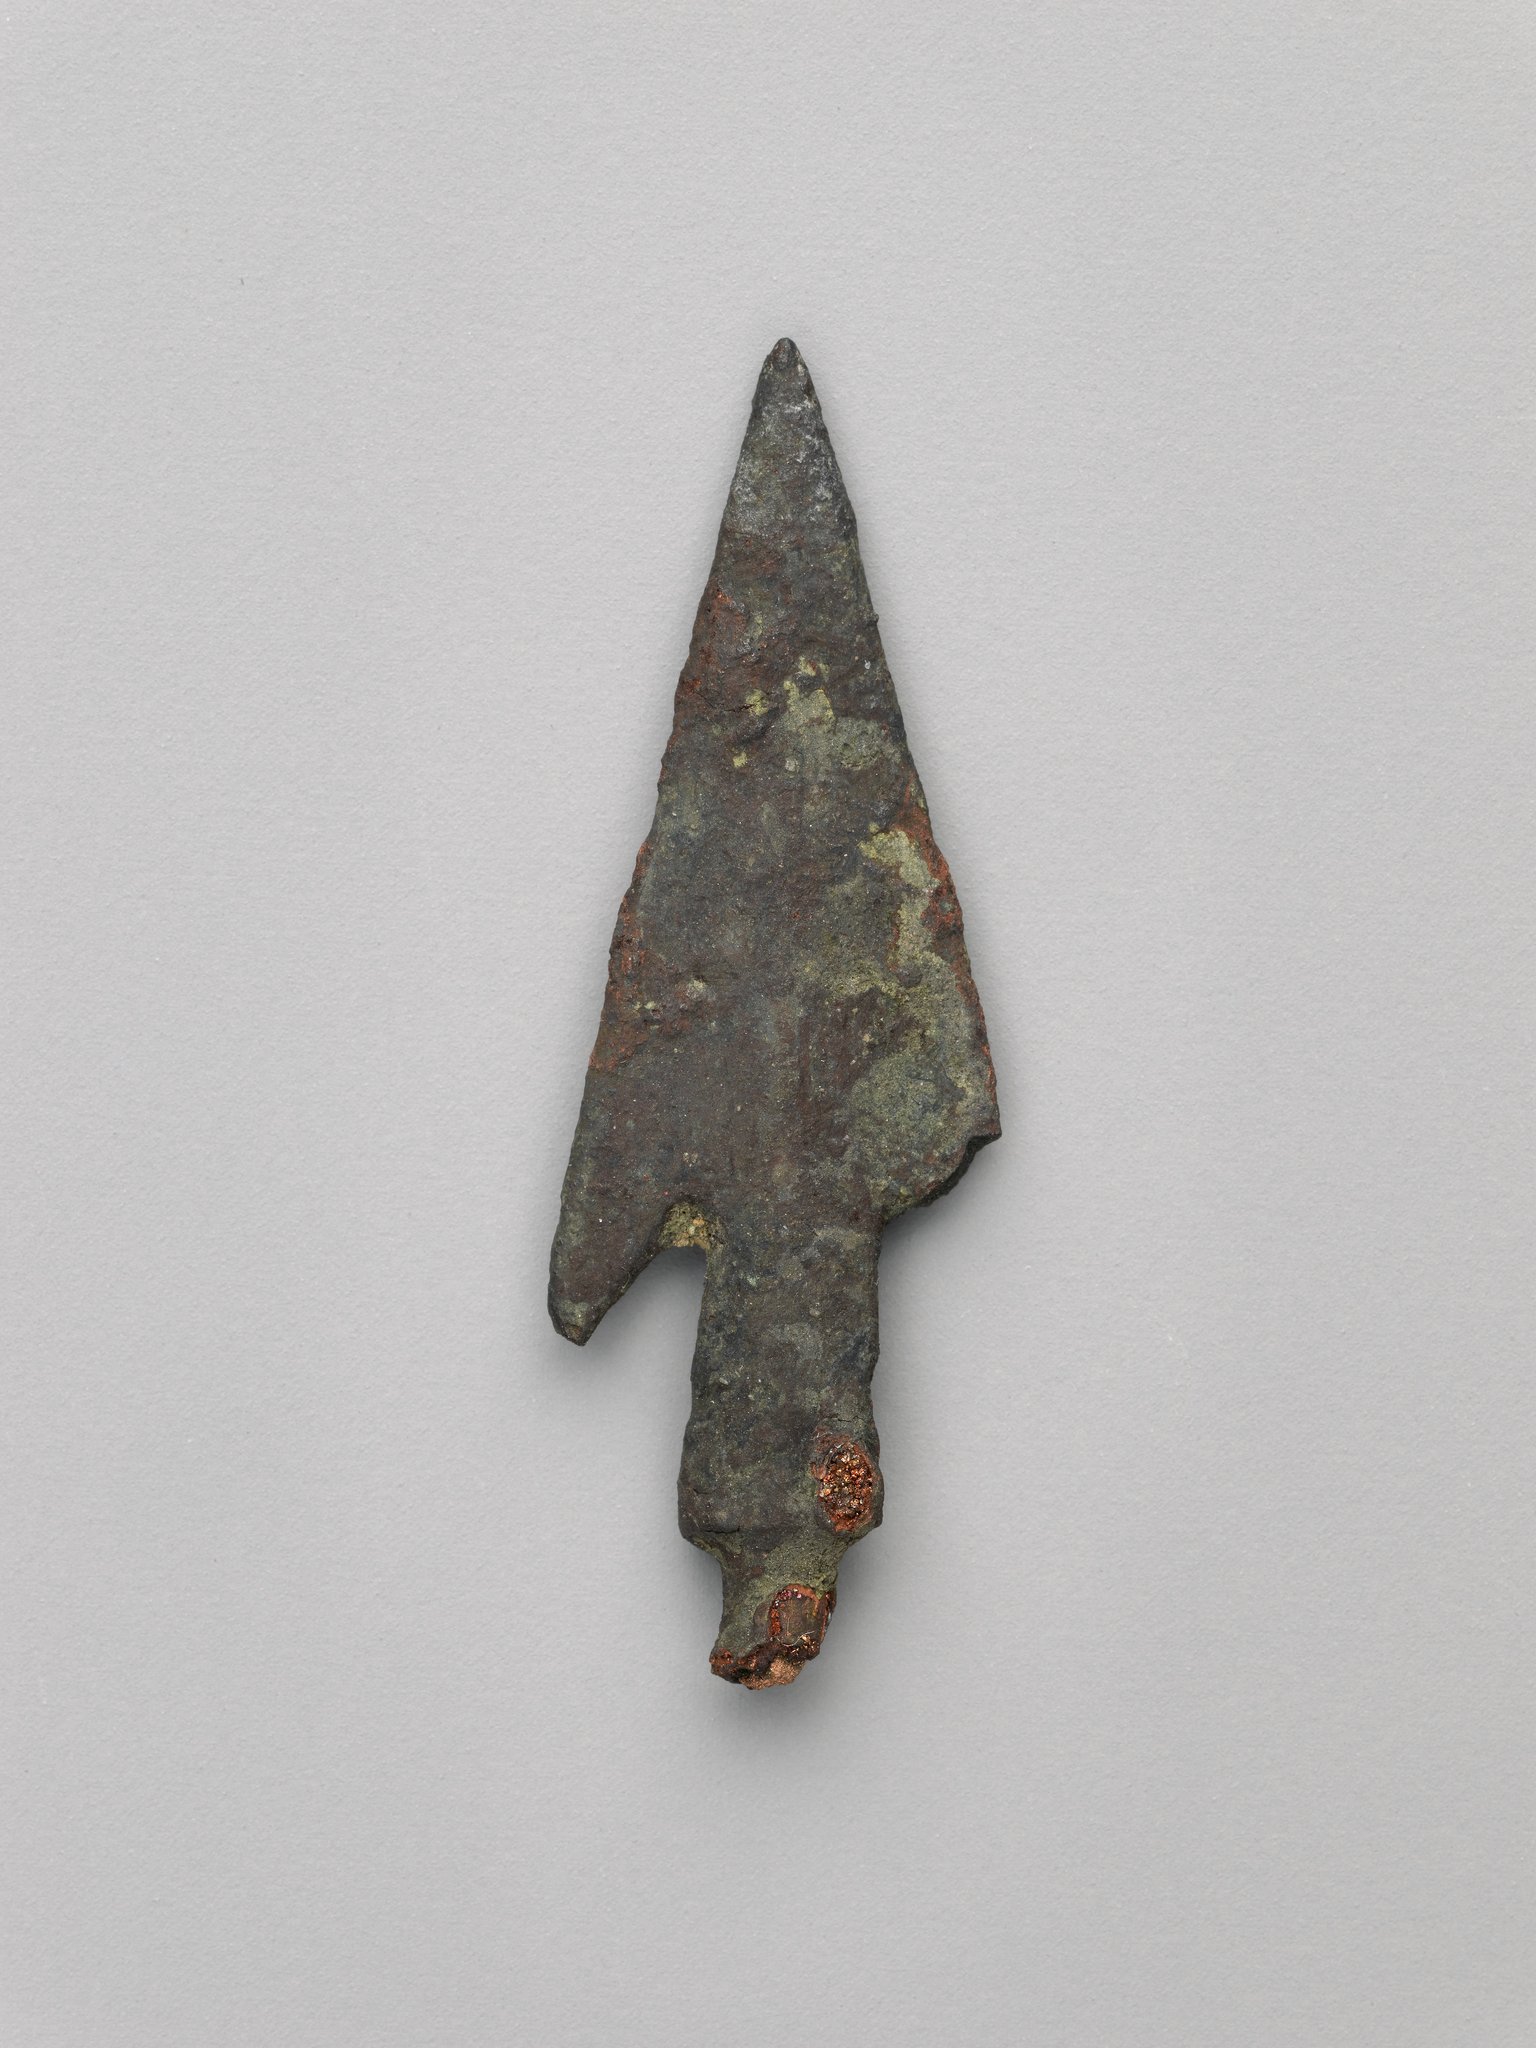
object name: arrowhead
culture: sasanian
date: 201-700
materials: bronze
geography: iran